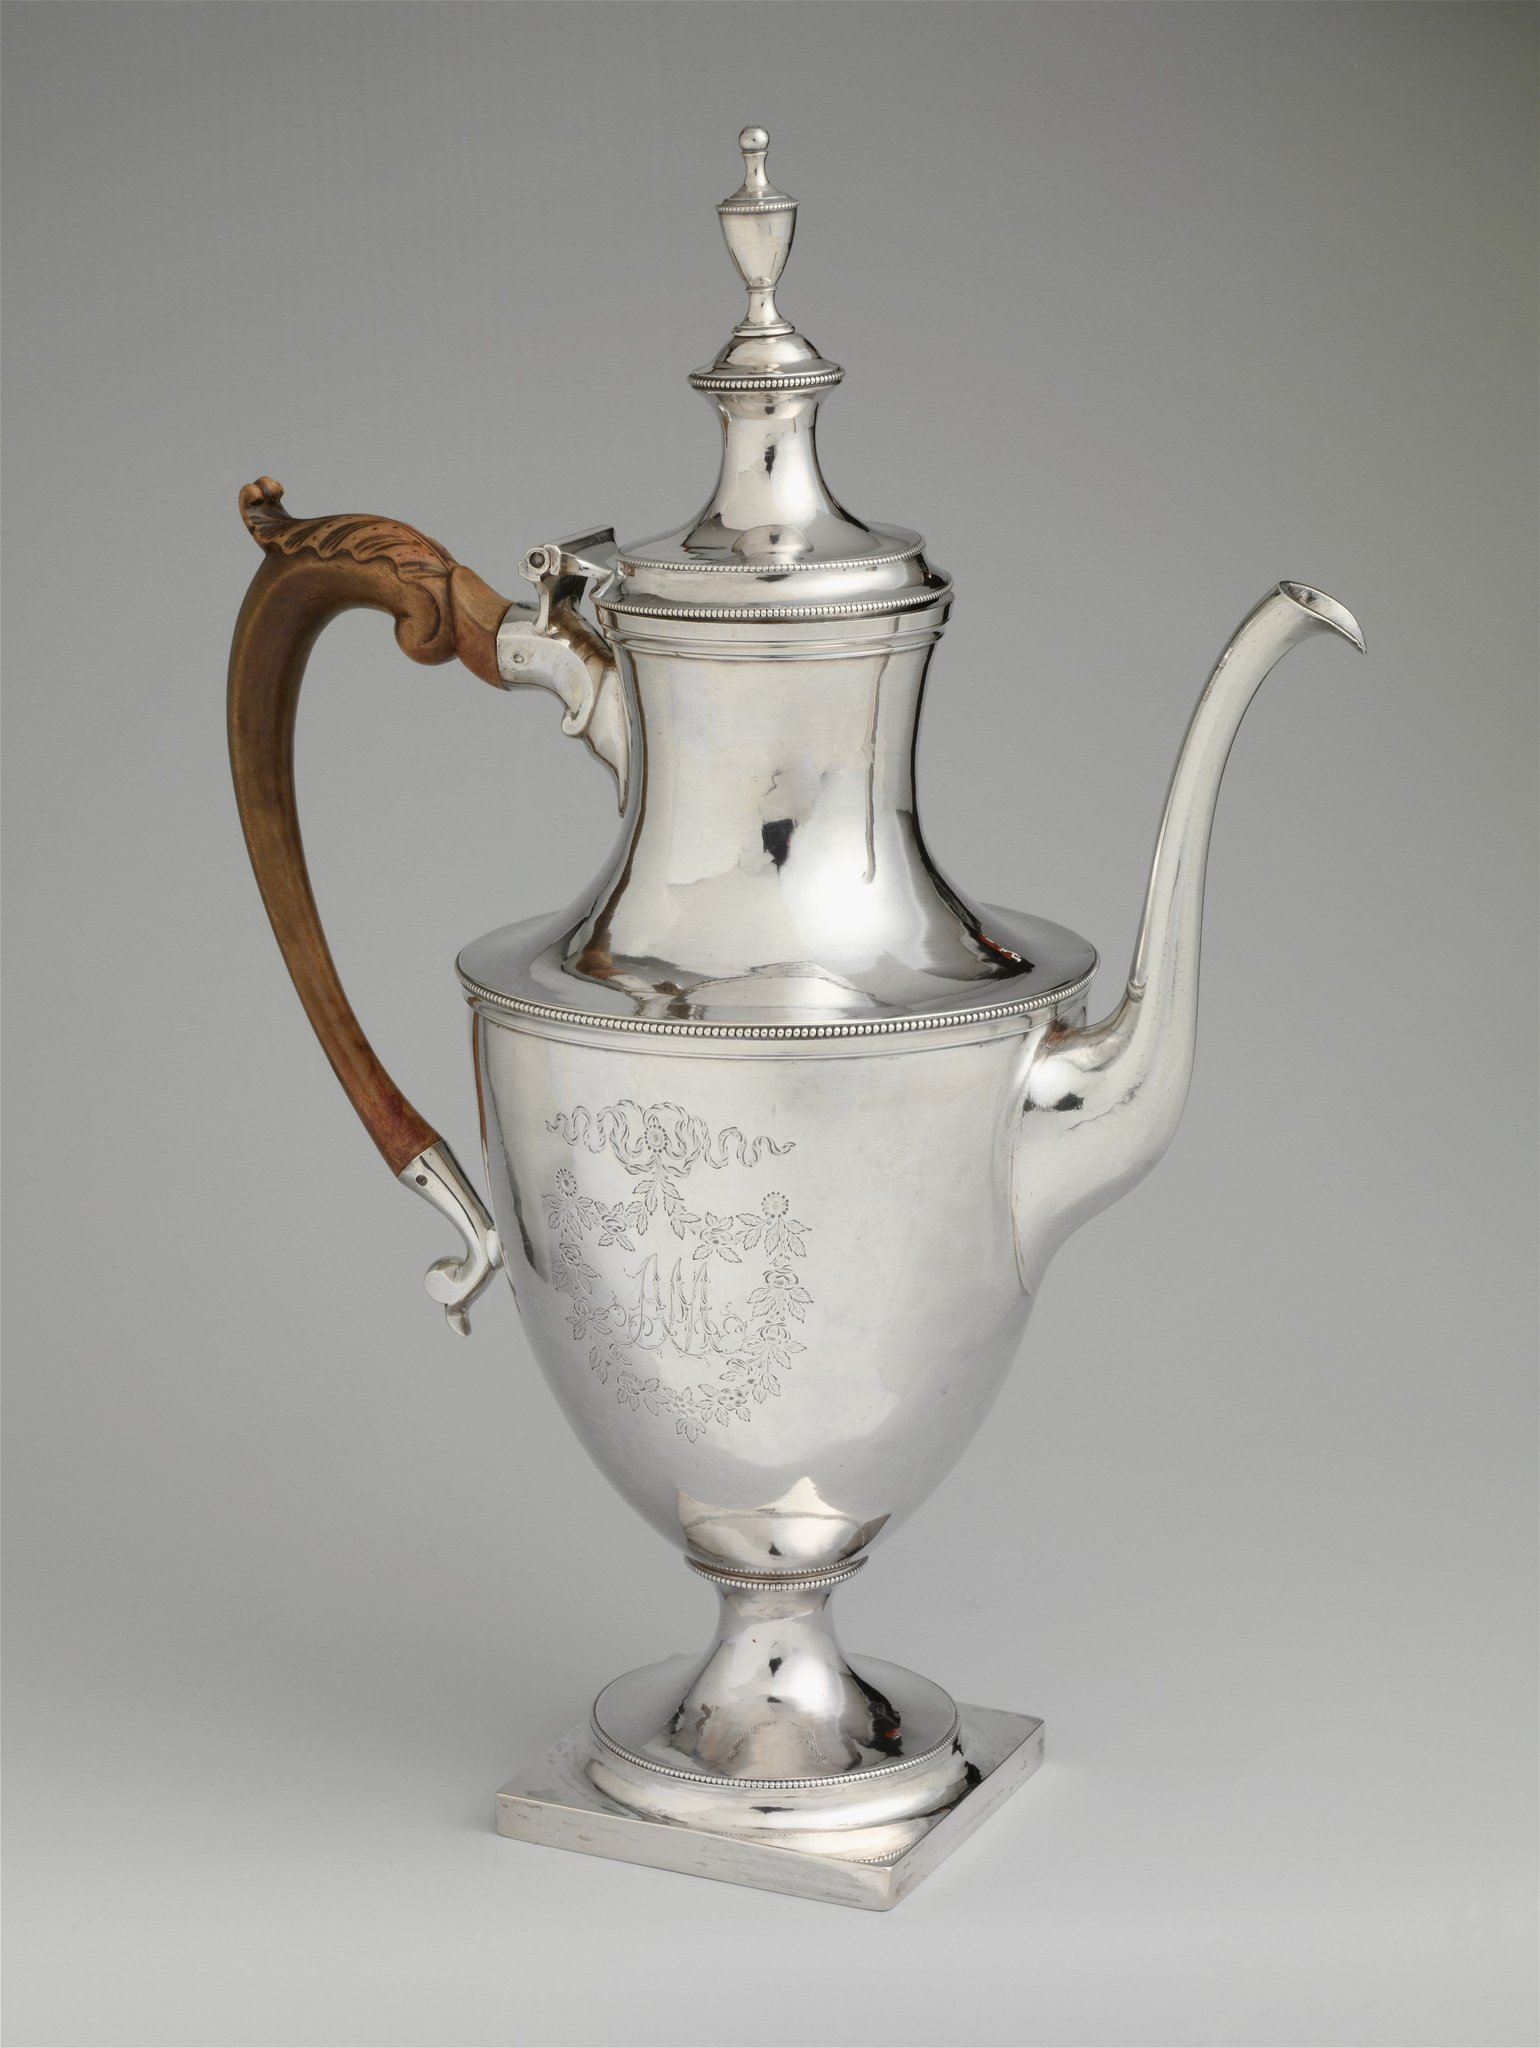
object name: coffeepot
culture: american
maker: joseph richardson jr.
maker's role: maker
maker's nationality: american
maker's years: 1752-1831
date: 1795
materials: silver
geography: united states